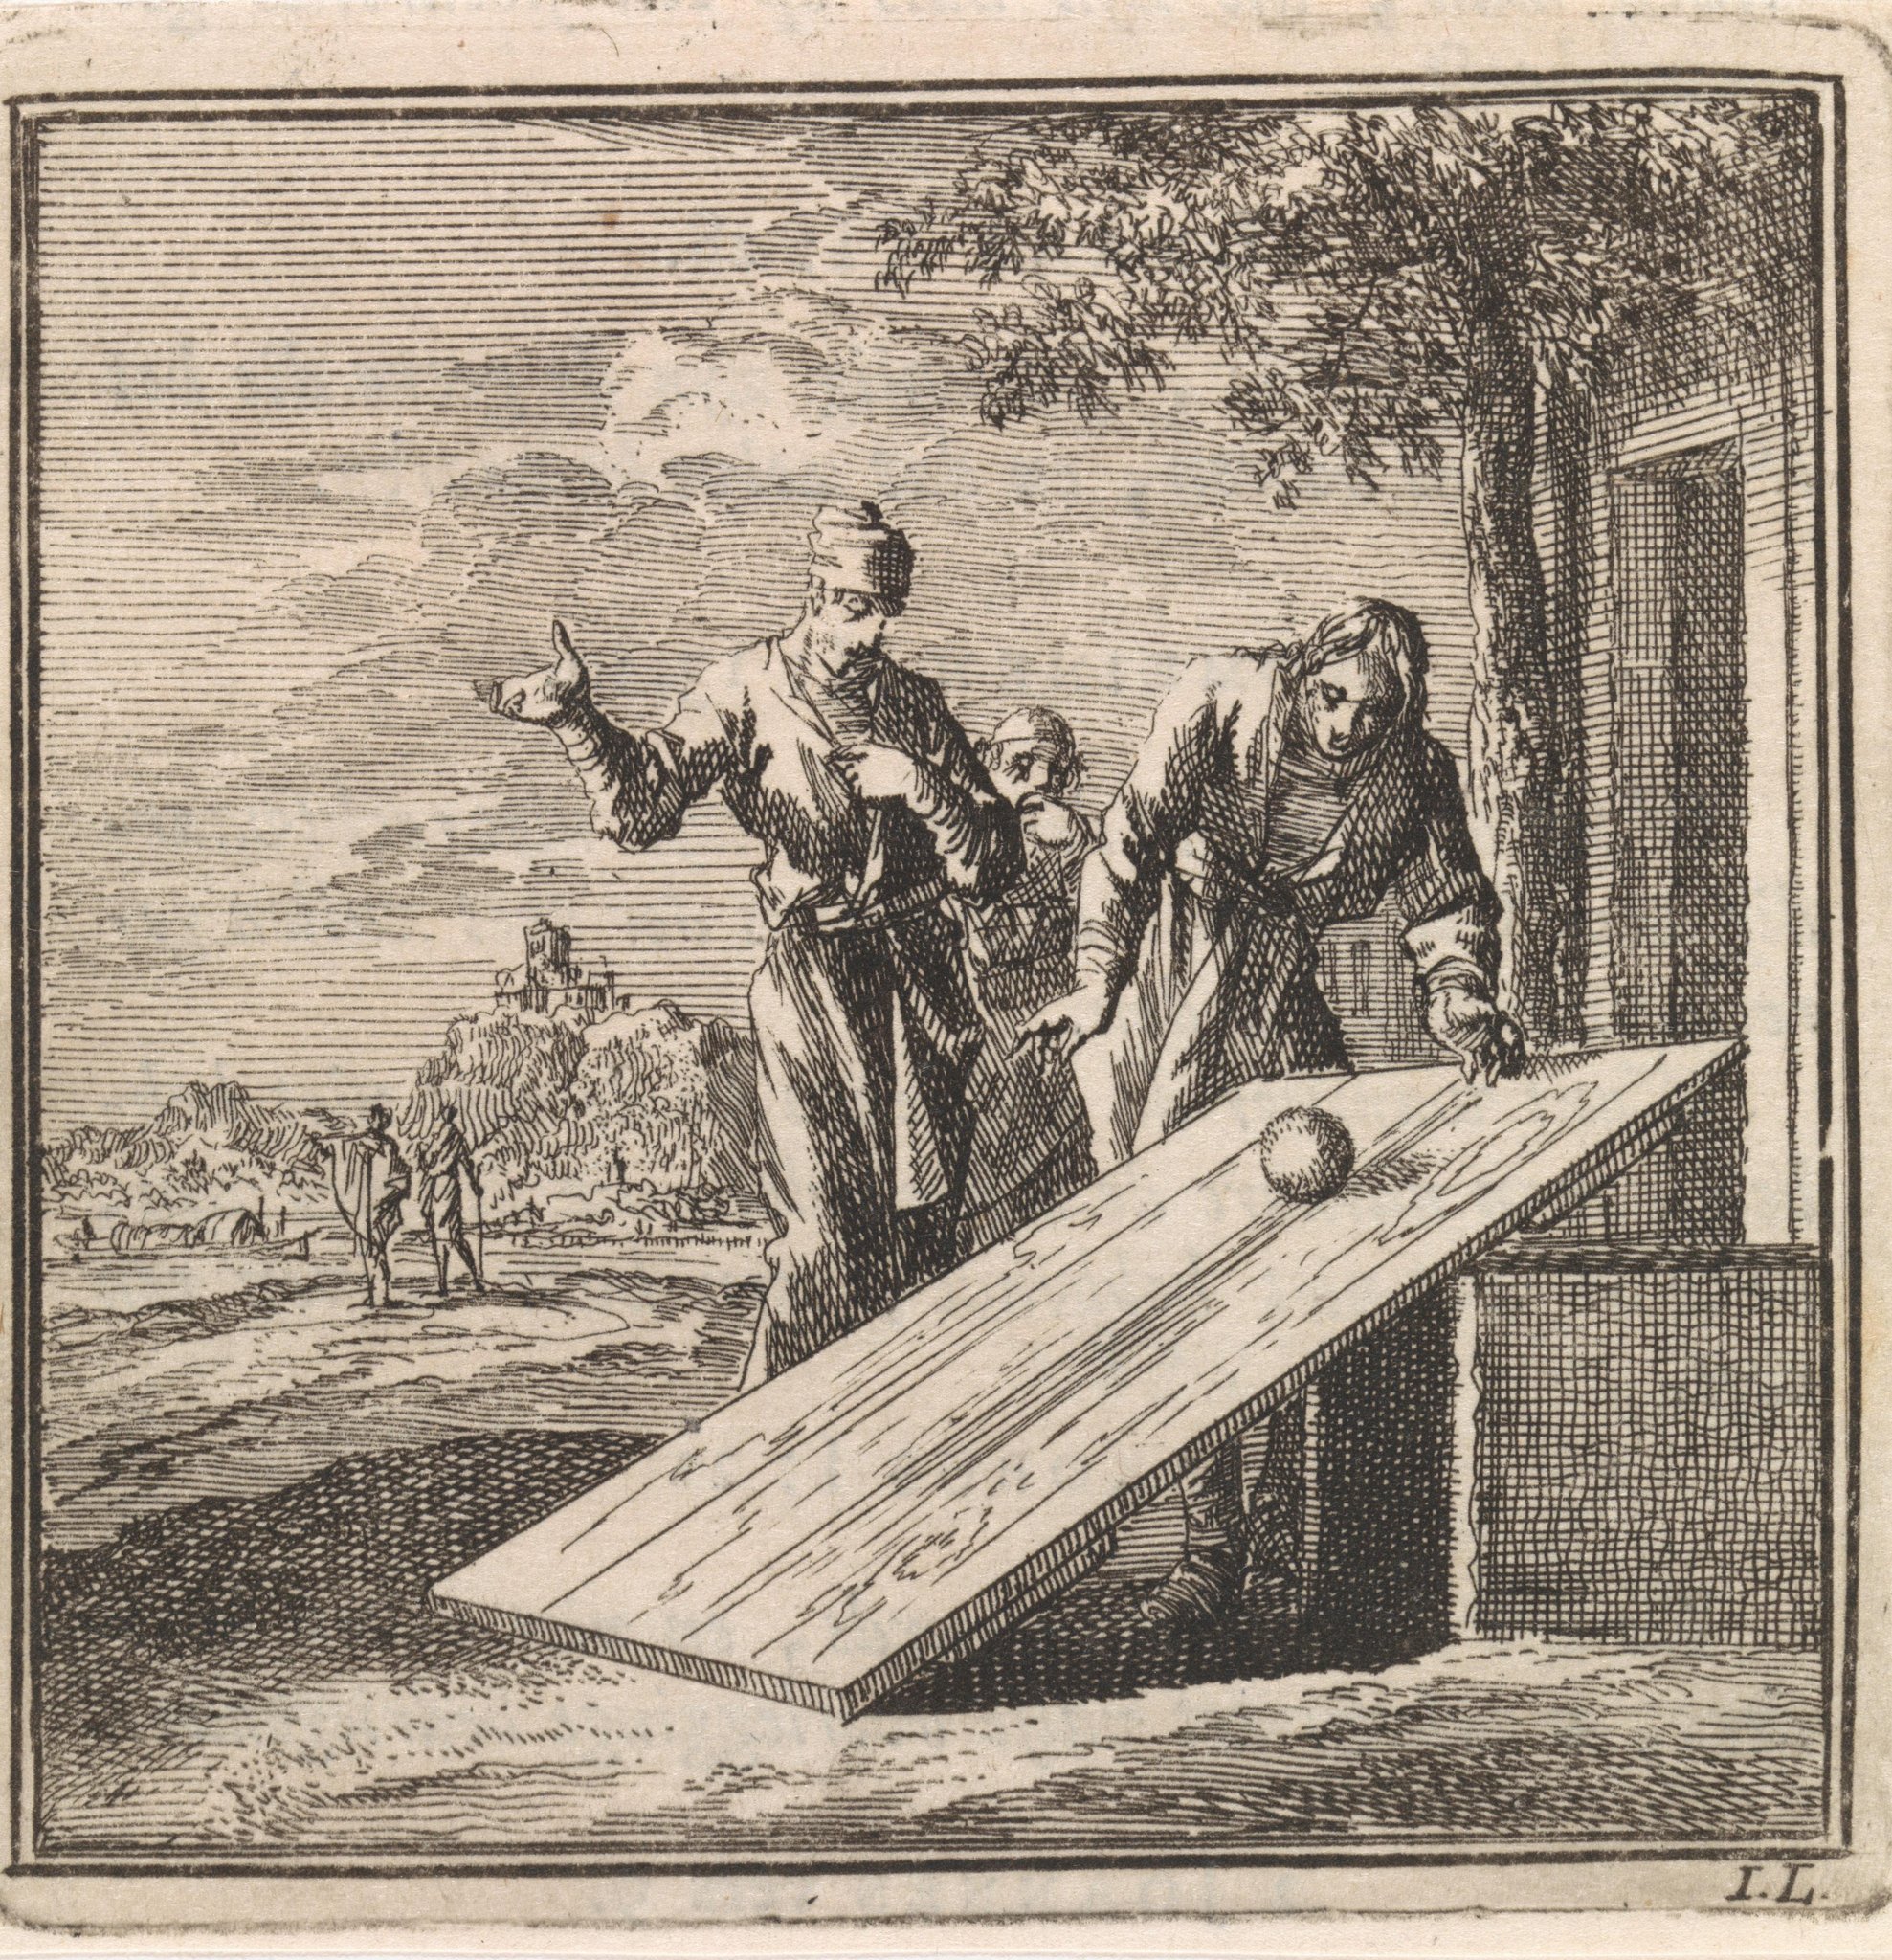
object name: book illustration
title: Het Schuin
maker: jan luyken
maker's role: draughtsman, print maker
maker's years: 1649-1712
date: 1711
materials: paper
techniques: etching, letterpress printing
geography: amsterdam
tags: plank, board ~ building material, ball games in which ball or bowl is rolled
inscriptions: collector's mark: Lugt 2228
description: Illustratie voor: Luyken, Jan. De Bykorf des Gemoeds. Amsterdam: Pieter Arentsz. II (wed.) en Cornelis van der Sys, 1711, p. 130.